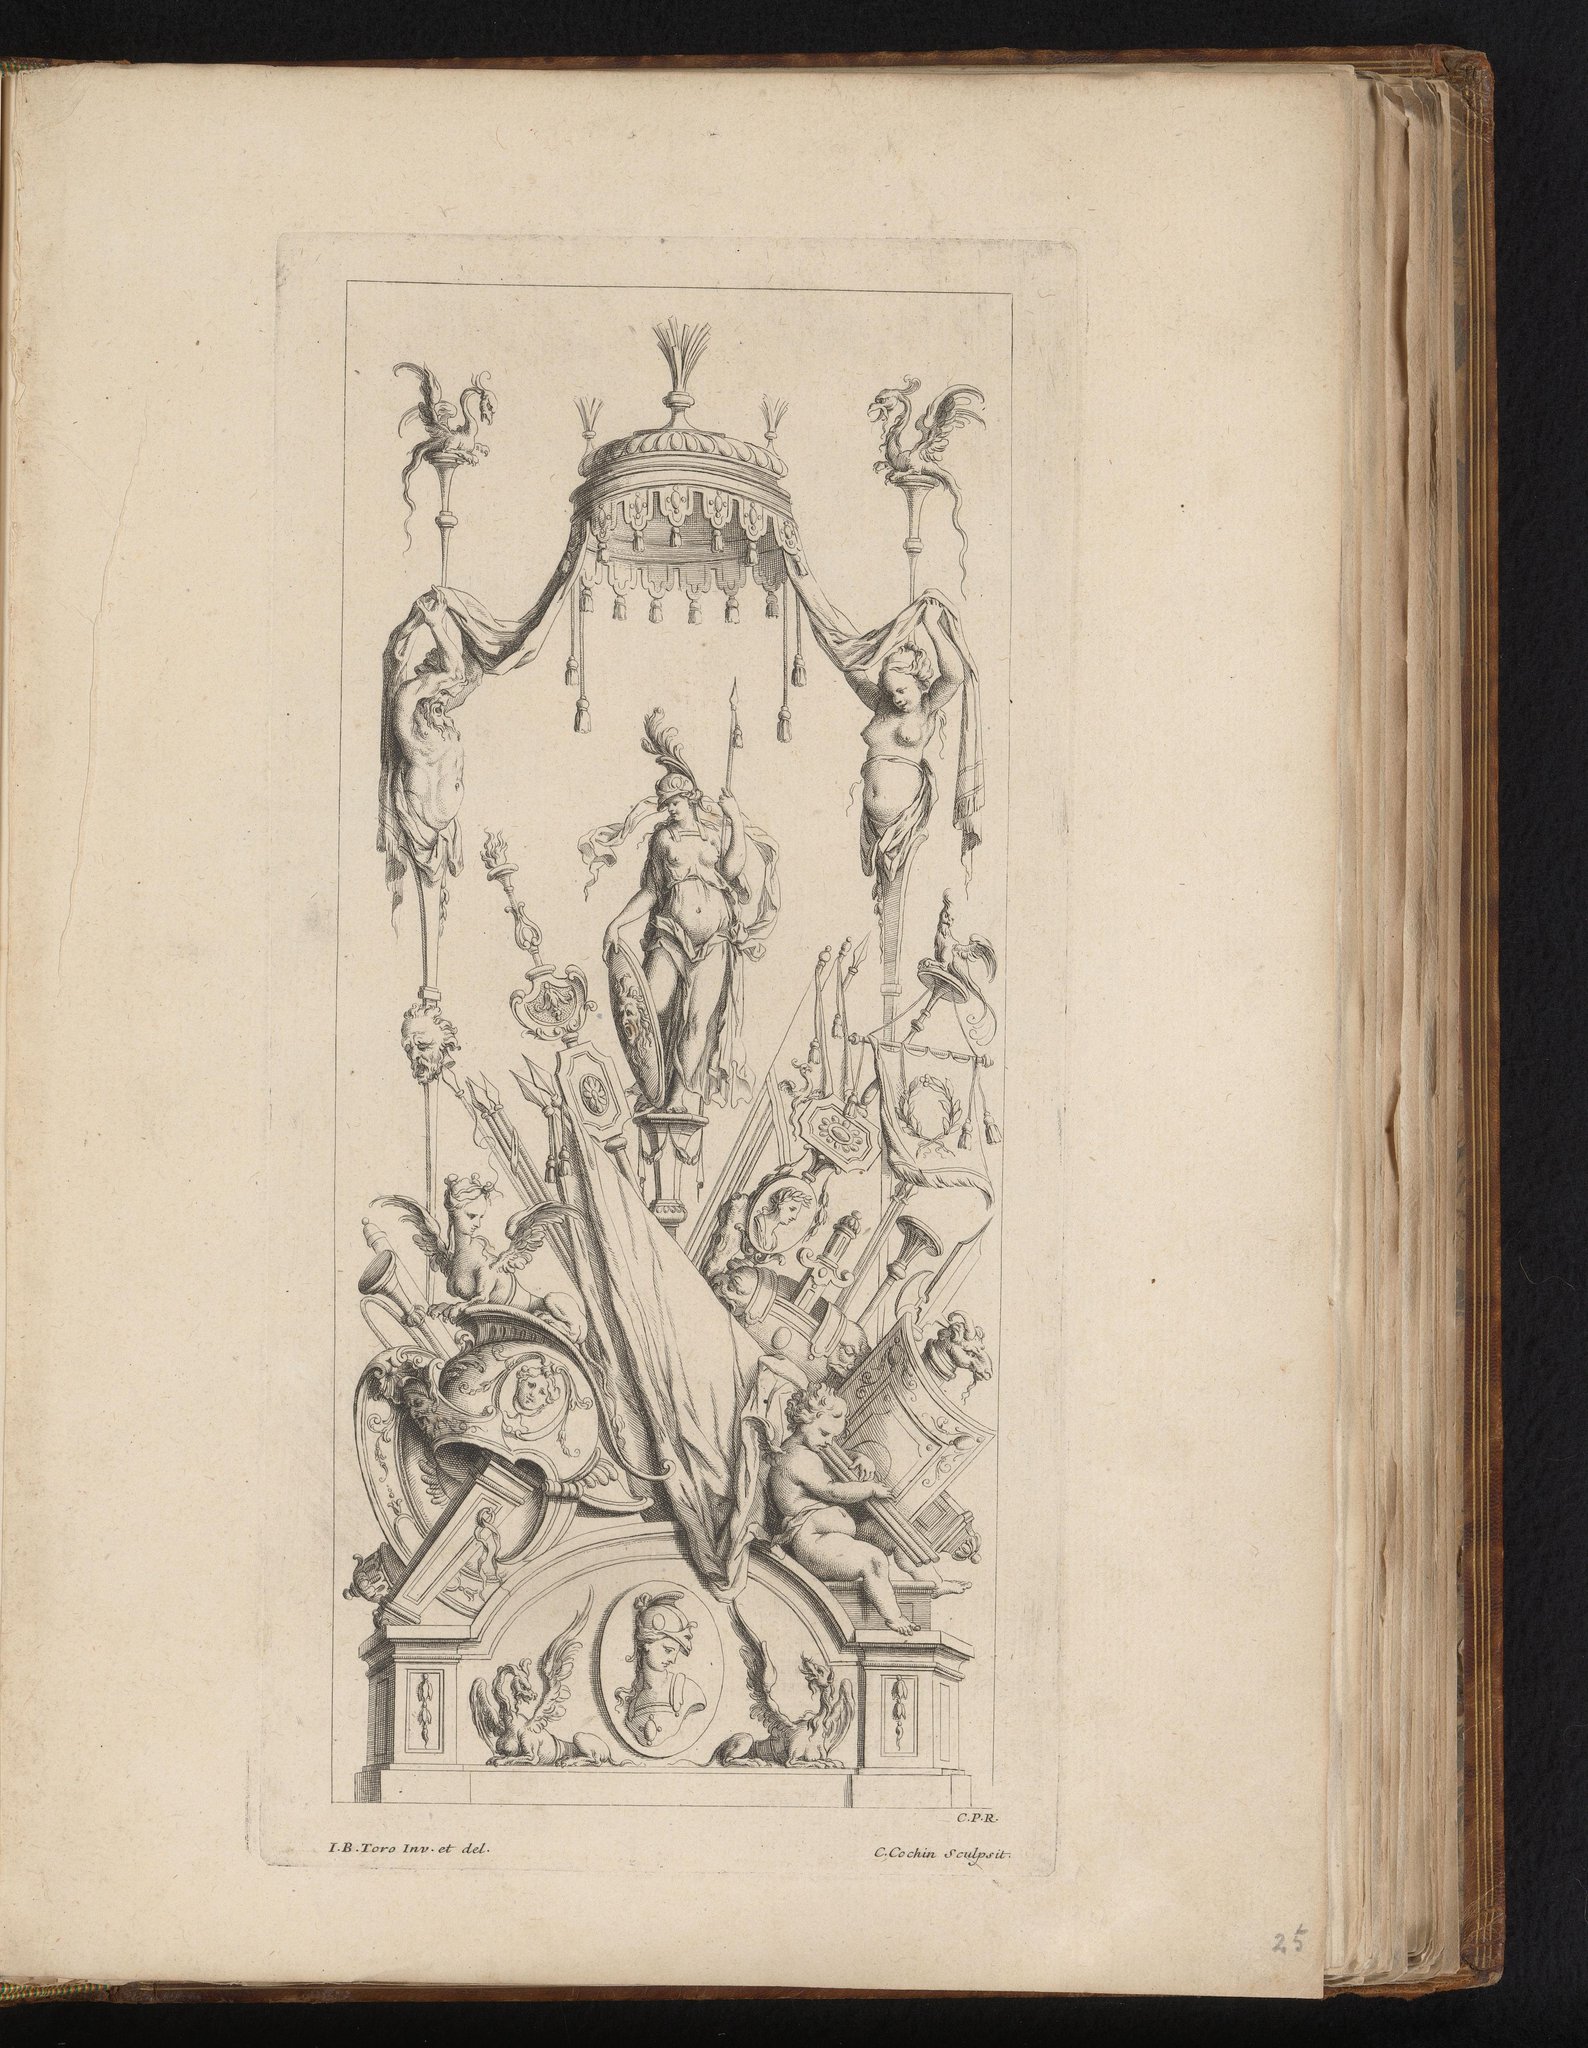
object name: album leaf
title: Ontwerpen voor ornamenten met oorlogstrofeeën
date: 1716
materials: paper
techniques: etching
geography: france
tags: 'tropaion', i.e. decorative ornament ~ weapons, (story of) minerva (pallas, athena), weapons, (military) flags and standards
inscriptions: collector's mark: Lugt 2228, collector's mark: Lugt 2760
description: Prent maakt deel uit van een serie van zes prenten.